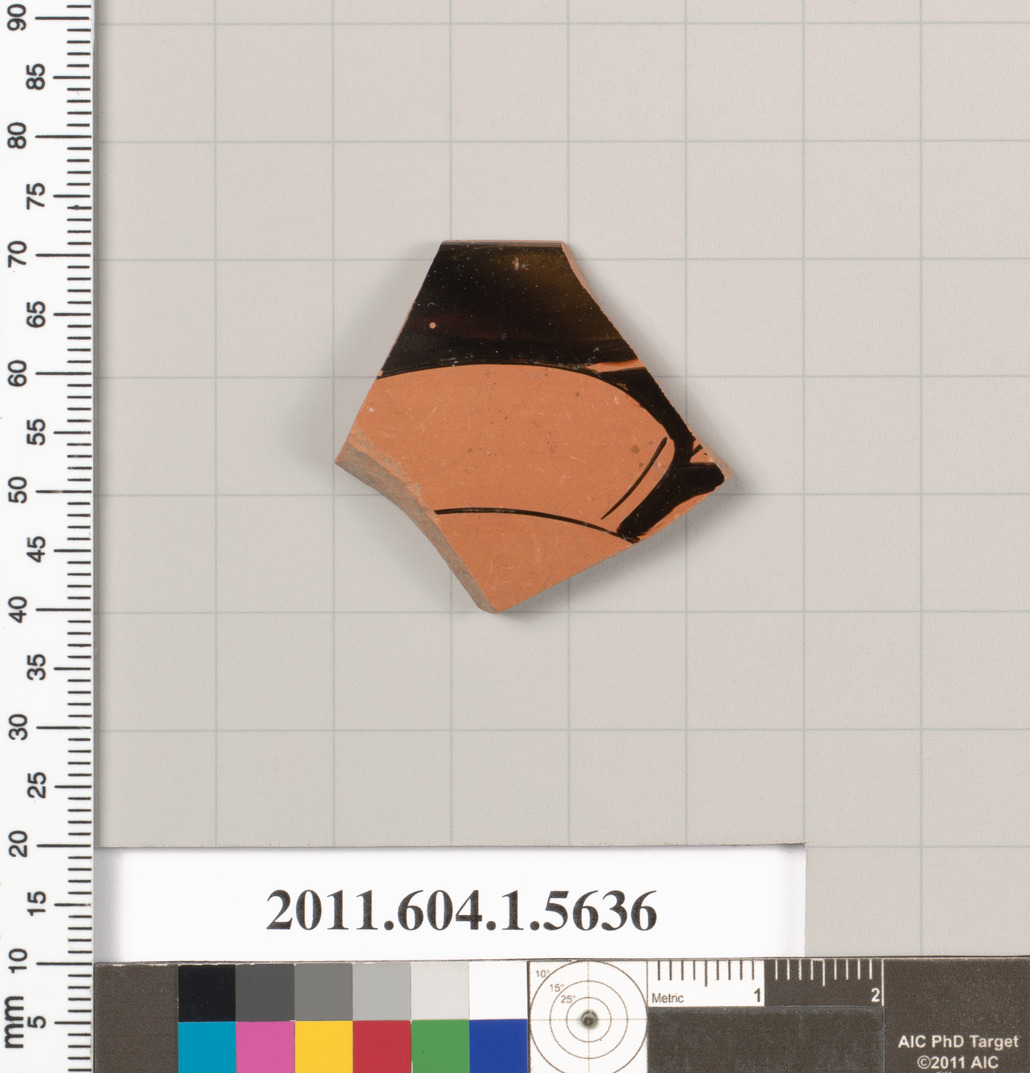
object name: kylix fragment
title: Terracotta rim fragment of a kylix (drinking cup)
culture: greek, attic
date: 510-490 BCE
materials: terracotta